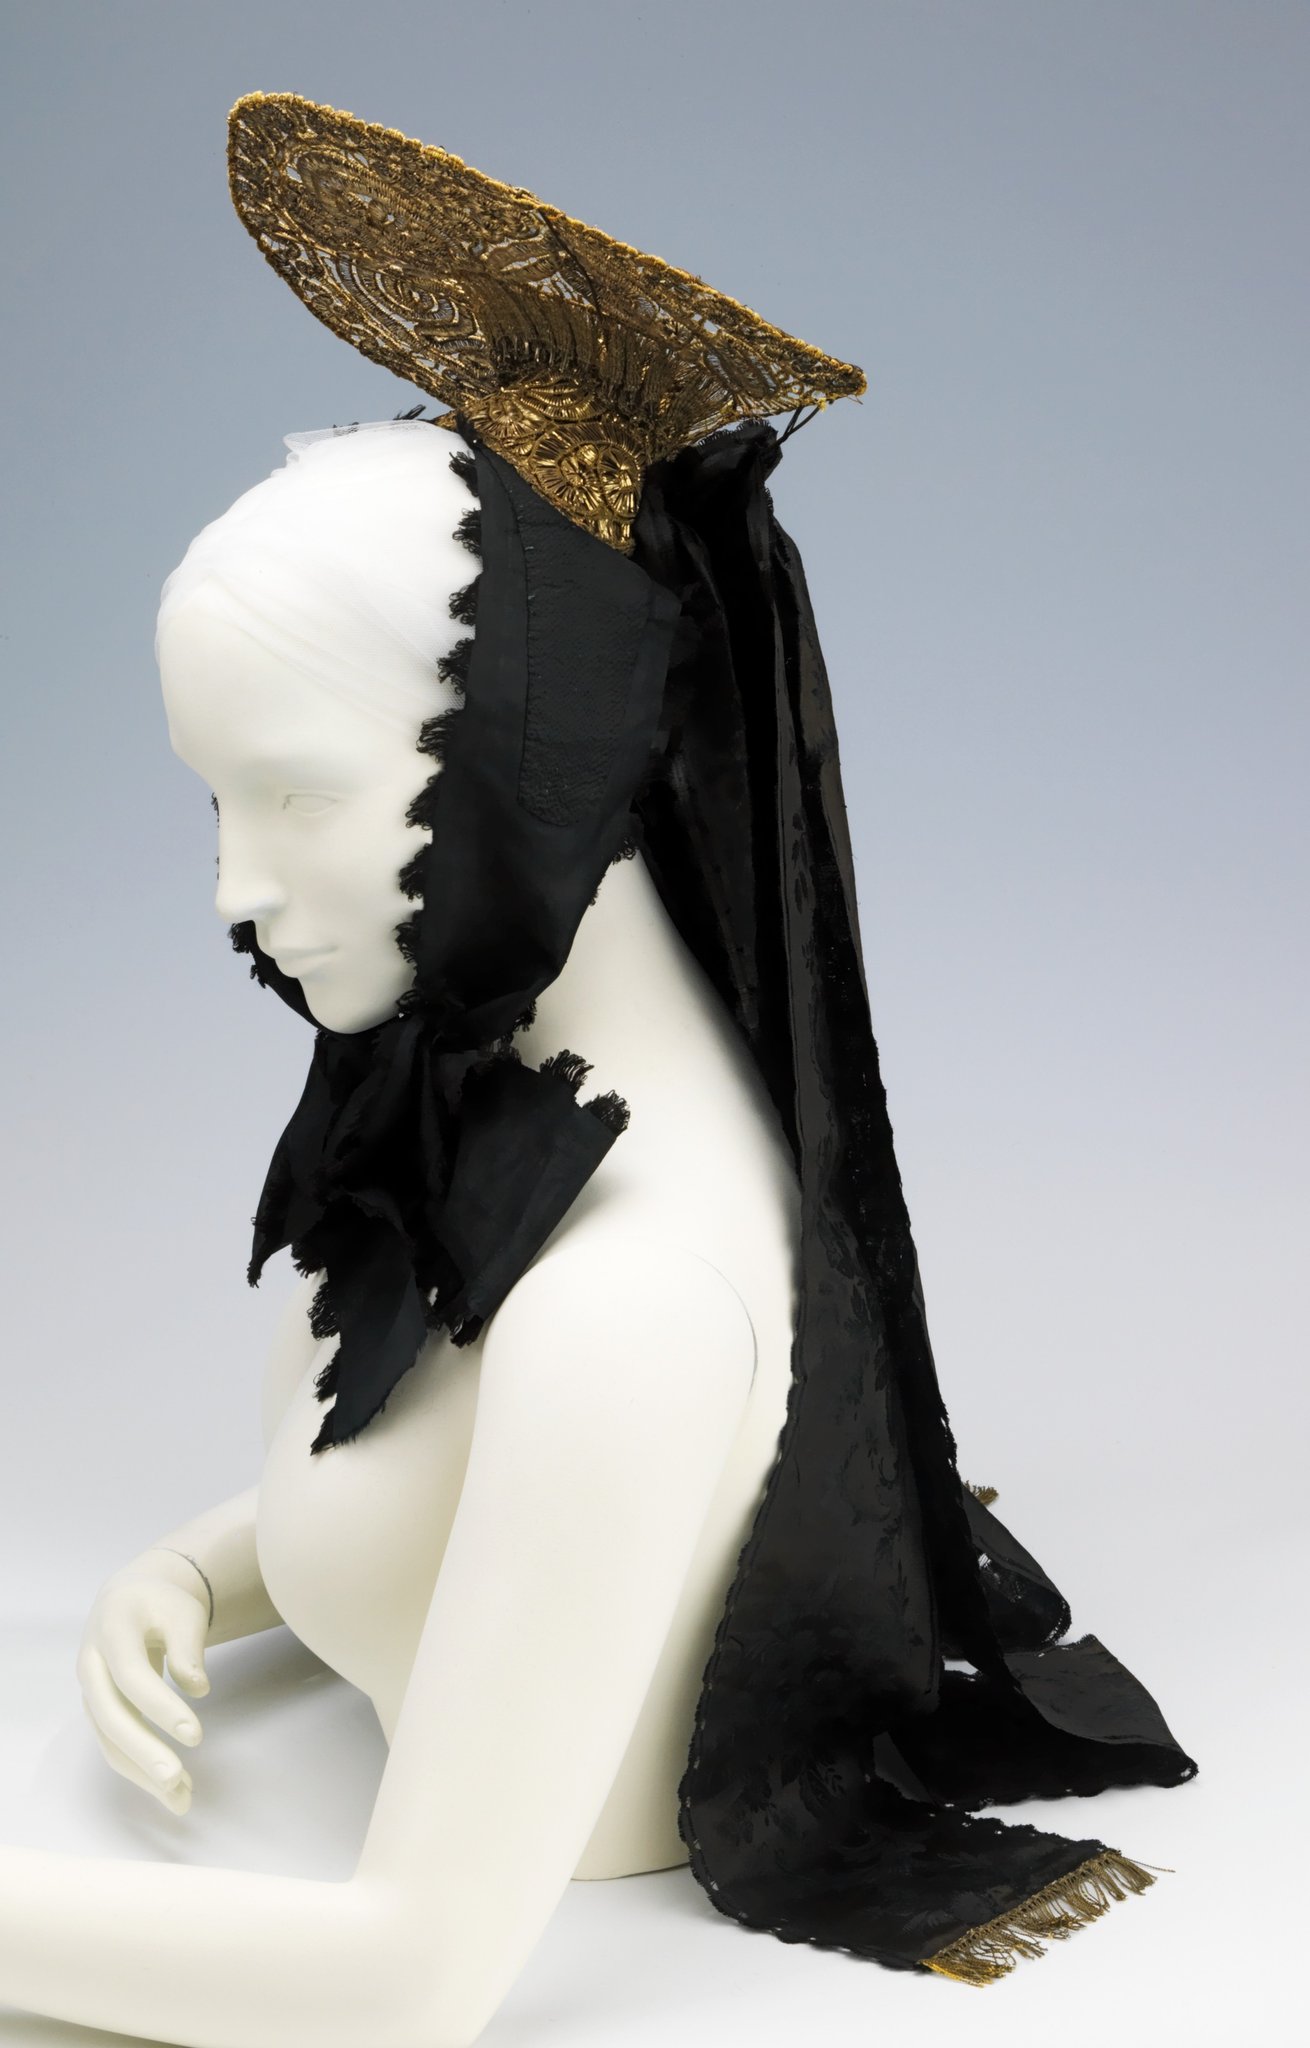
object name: headdress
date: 1876-1900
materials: cotton, metal, silk